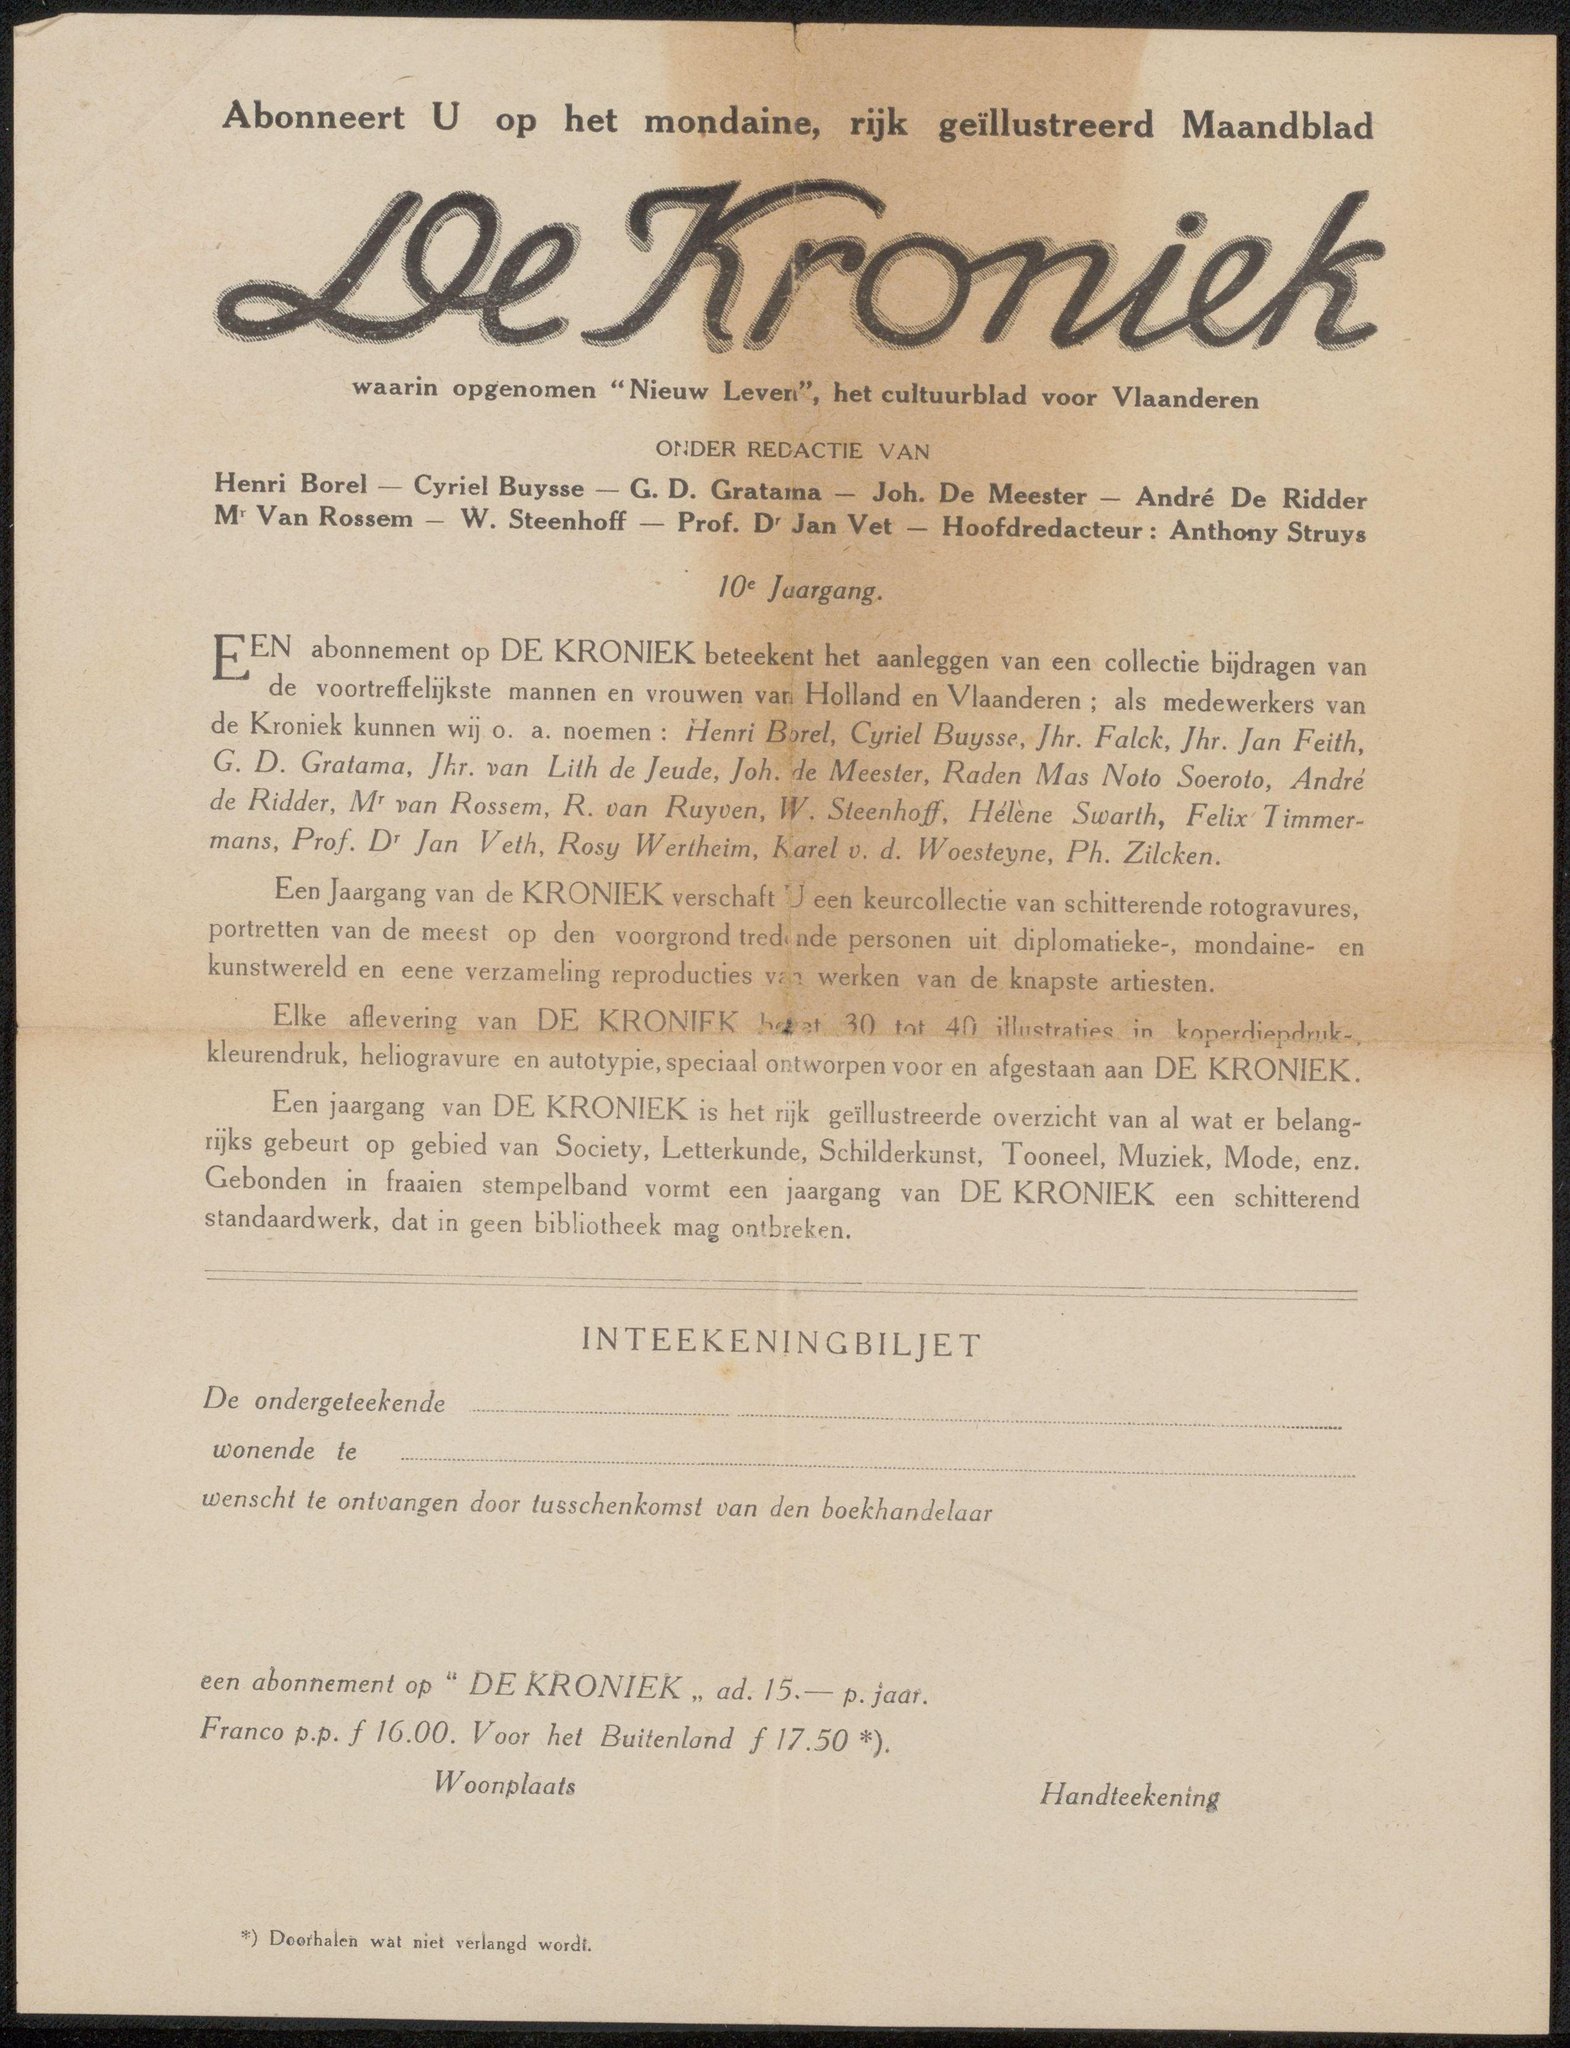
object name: biljet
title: Biljet uit archief Philip Zilcken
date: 1867-1930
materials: paper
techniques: printing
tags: the hague, painter, draughtsman, philip zilcken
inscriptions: collector's mark: ‘RPK’